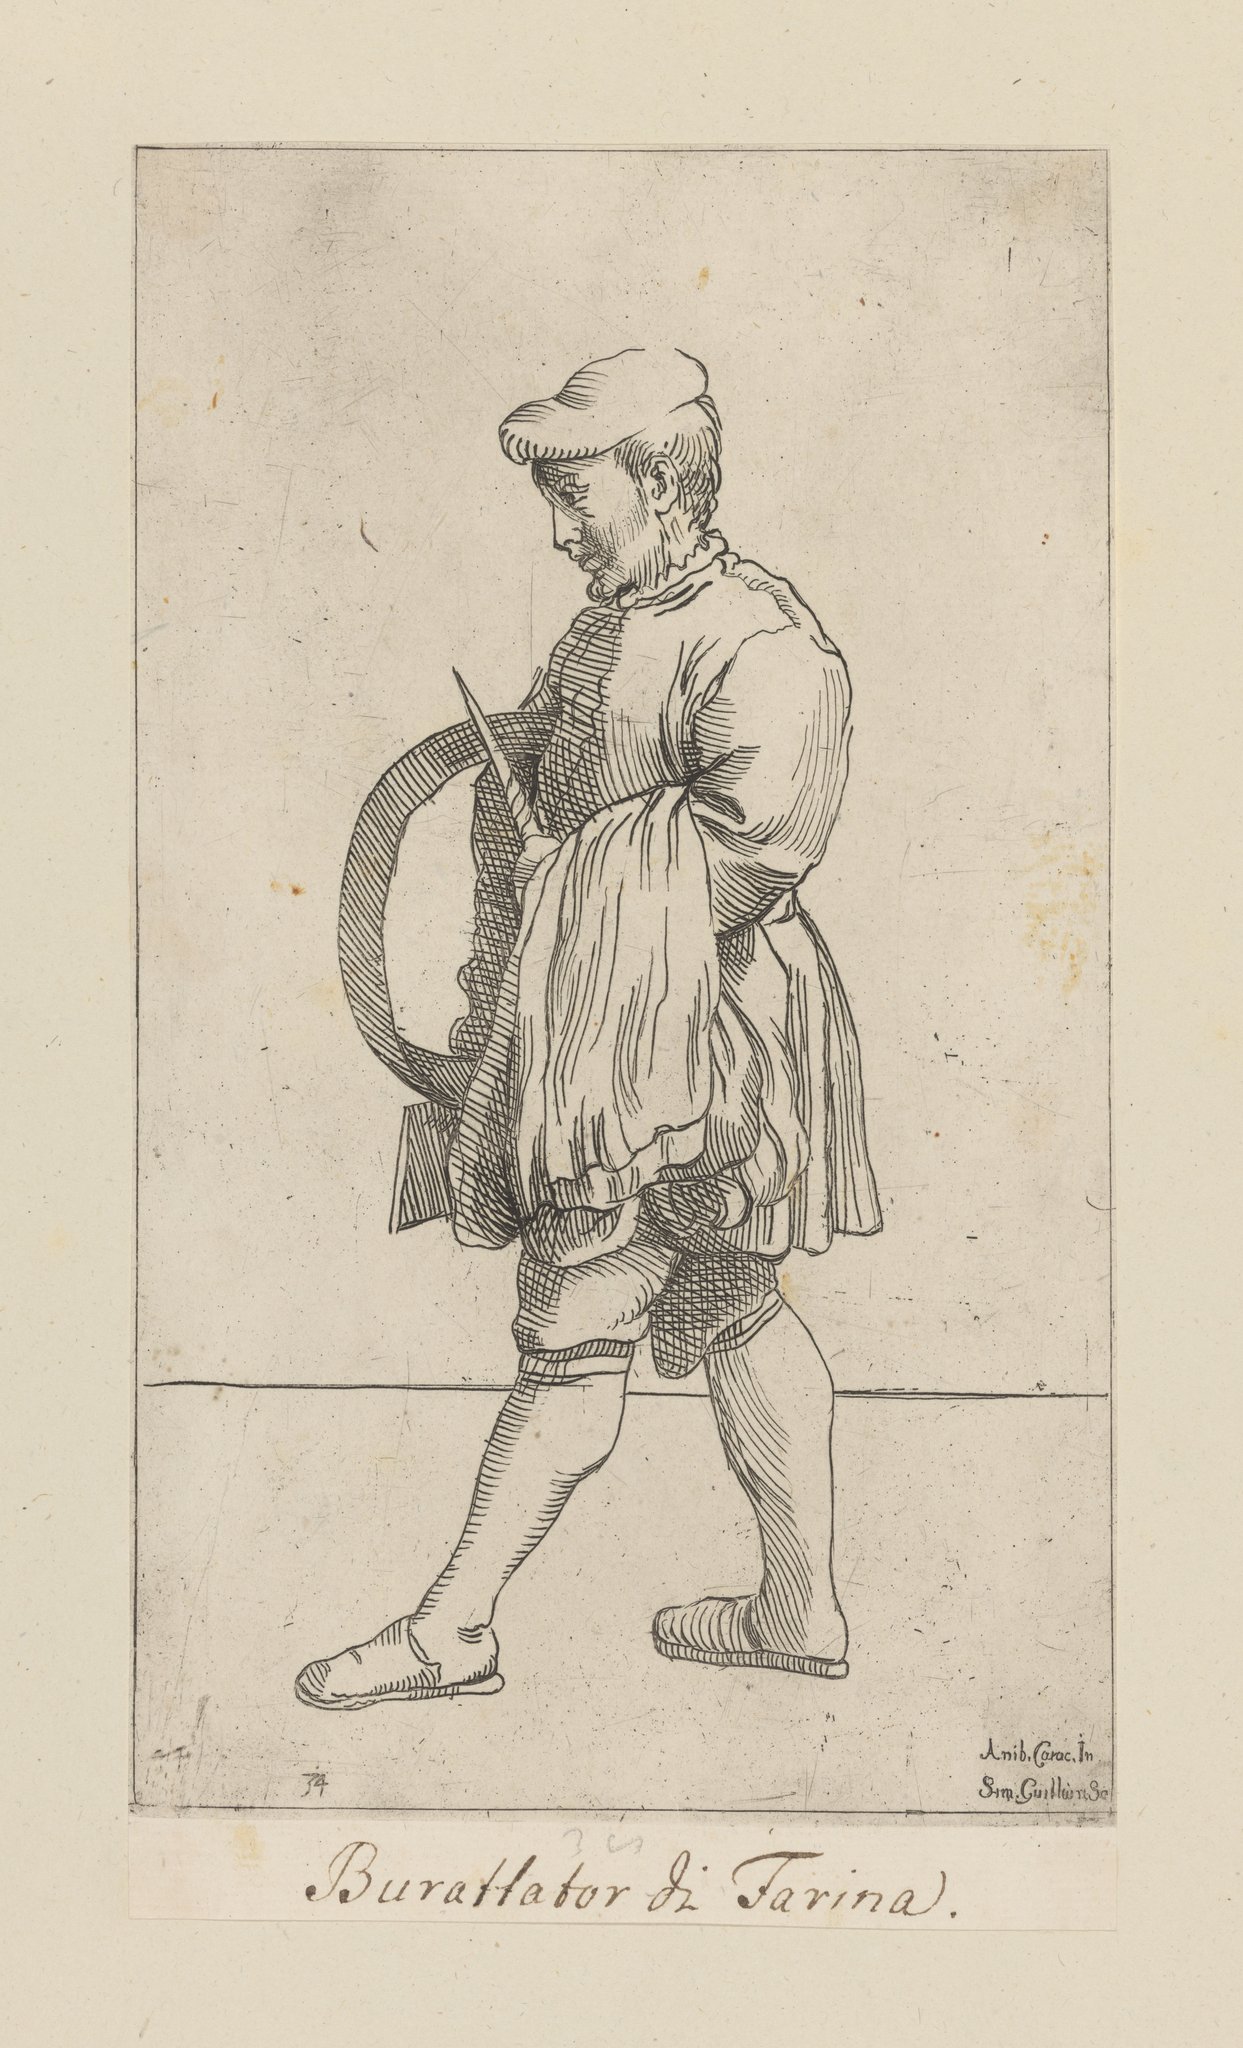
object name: print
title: Plate 34: Flour sifter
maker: simon guillain ii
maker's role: artist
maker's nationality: french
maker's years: 1618-1718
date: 1646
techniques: etching